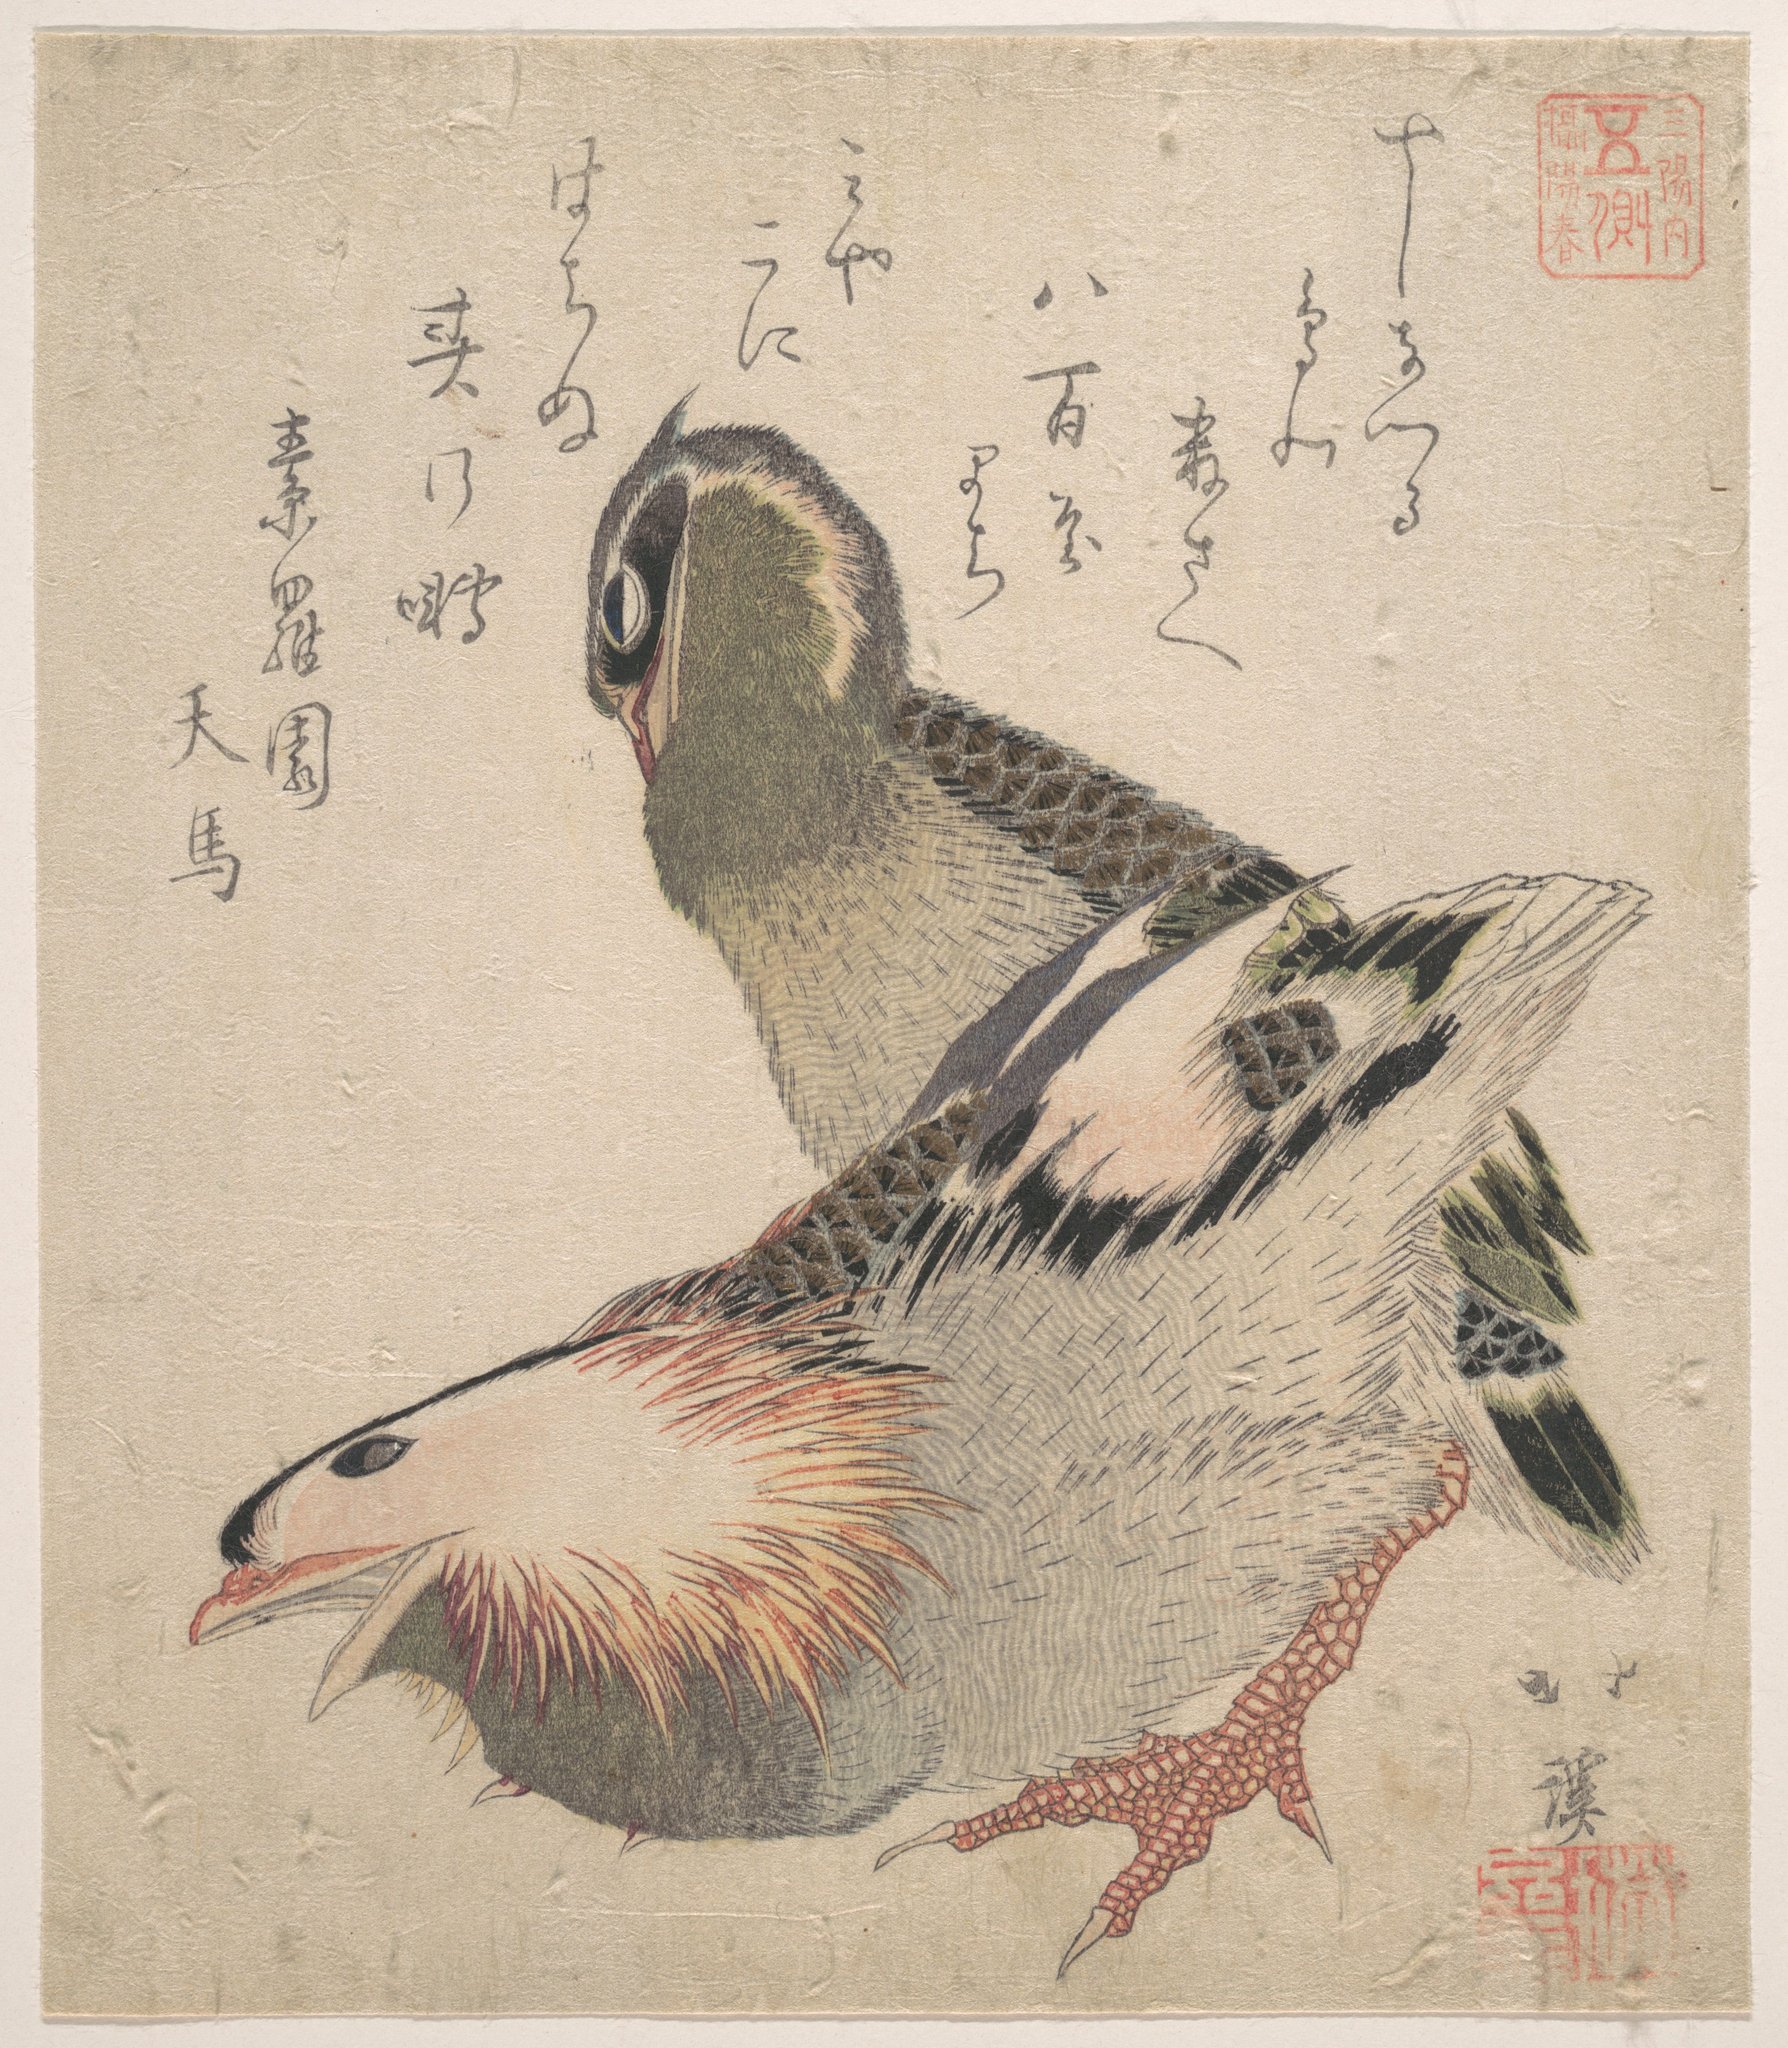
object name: print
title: Two Birds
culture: japanese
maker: totoya hokkei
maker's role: artist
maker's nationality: japanese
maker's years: 1780-1850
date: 1780-1850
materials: ink, paper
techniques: surimono, woodblock print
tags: birds